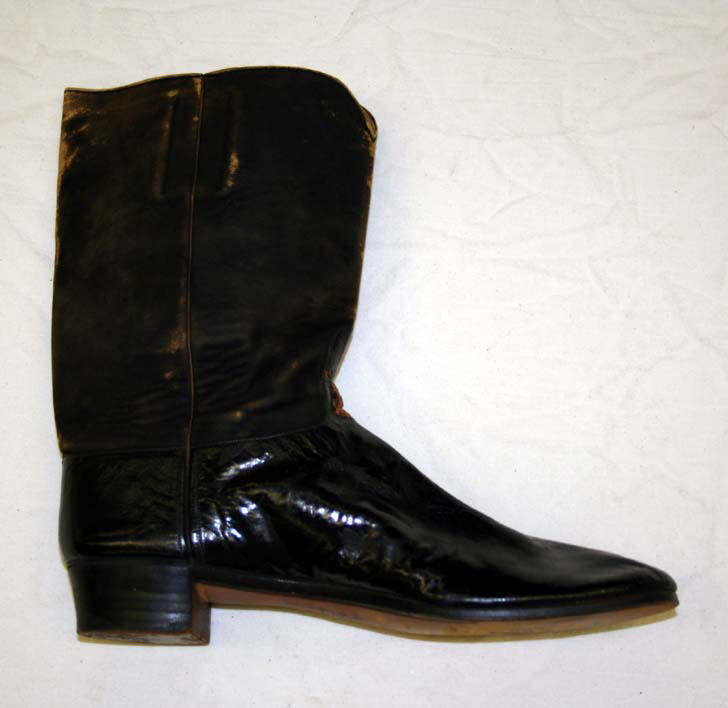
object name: boot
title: Boots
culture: french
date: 1878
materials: leather